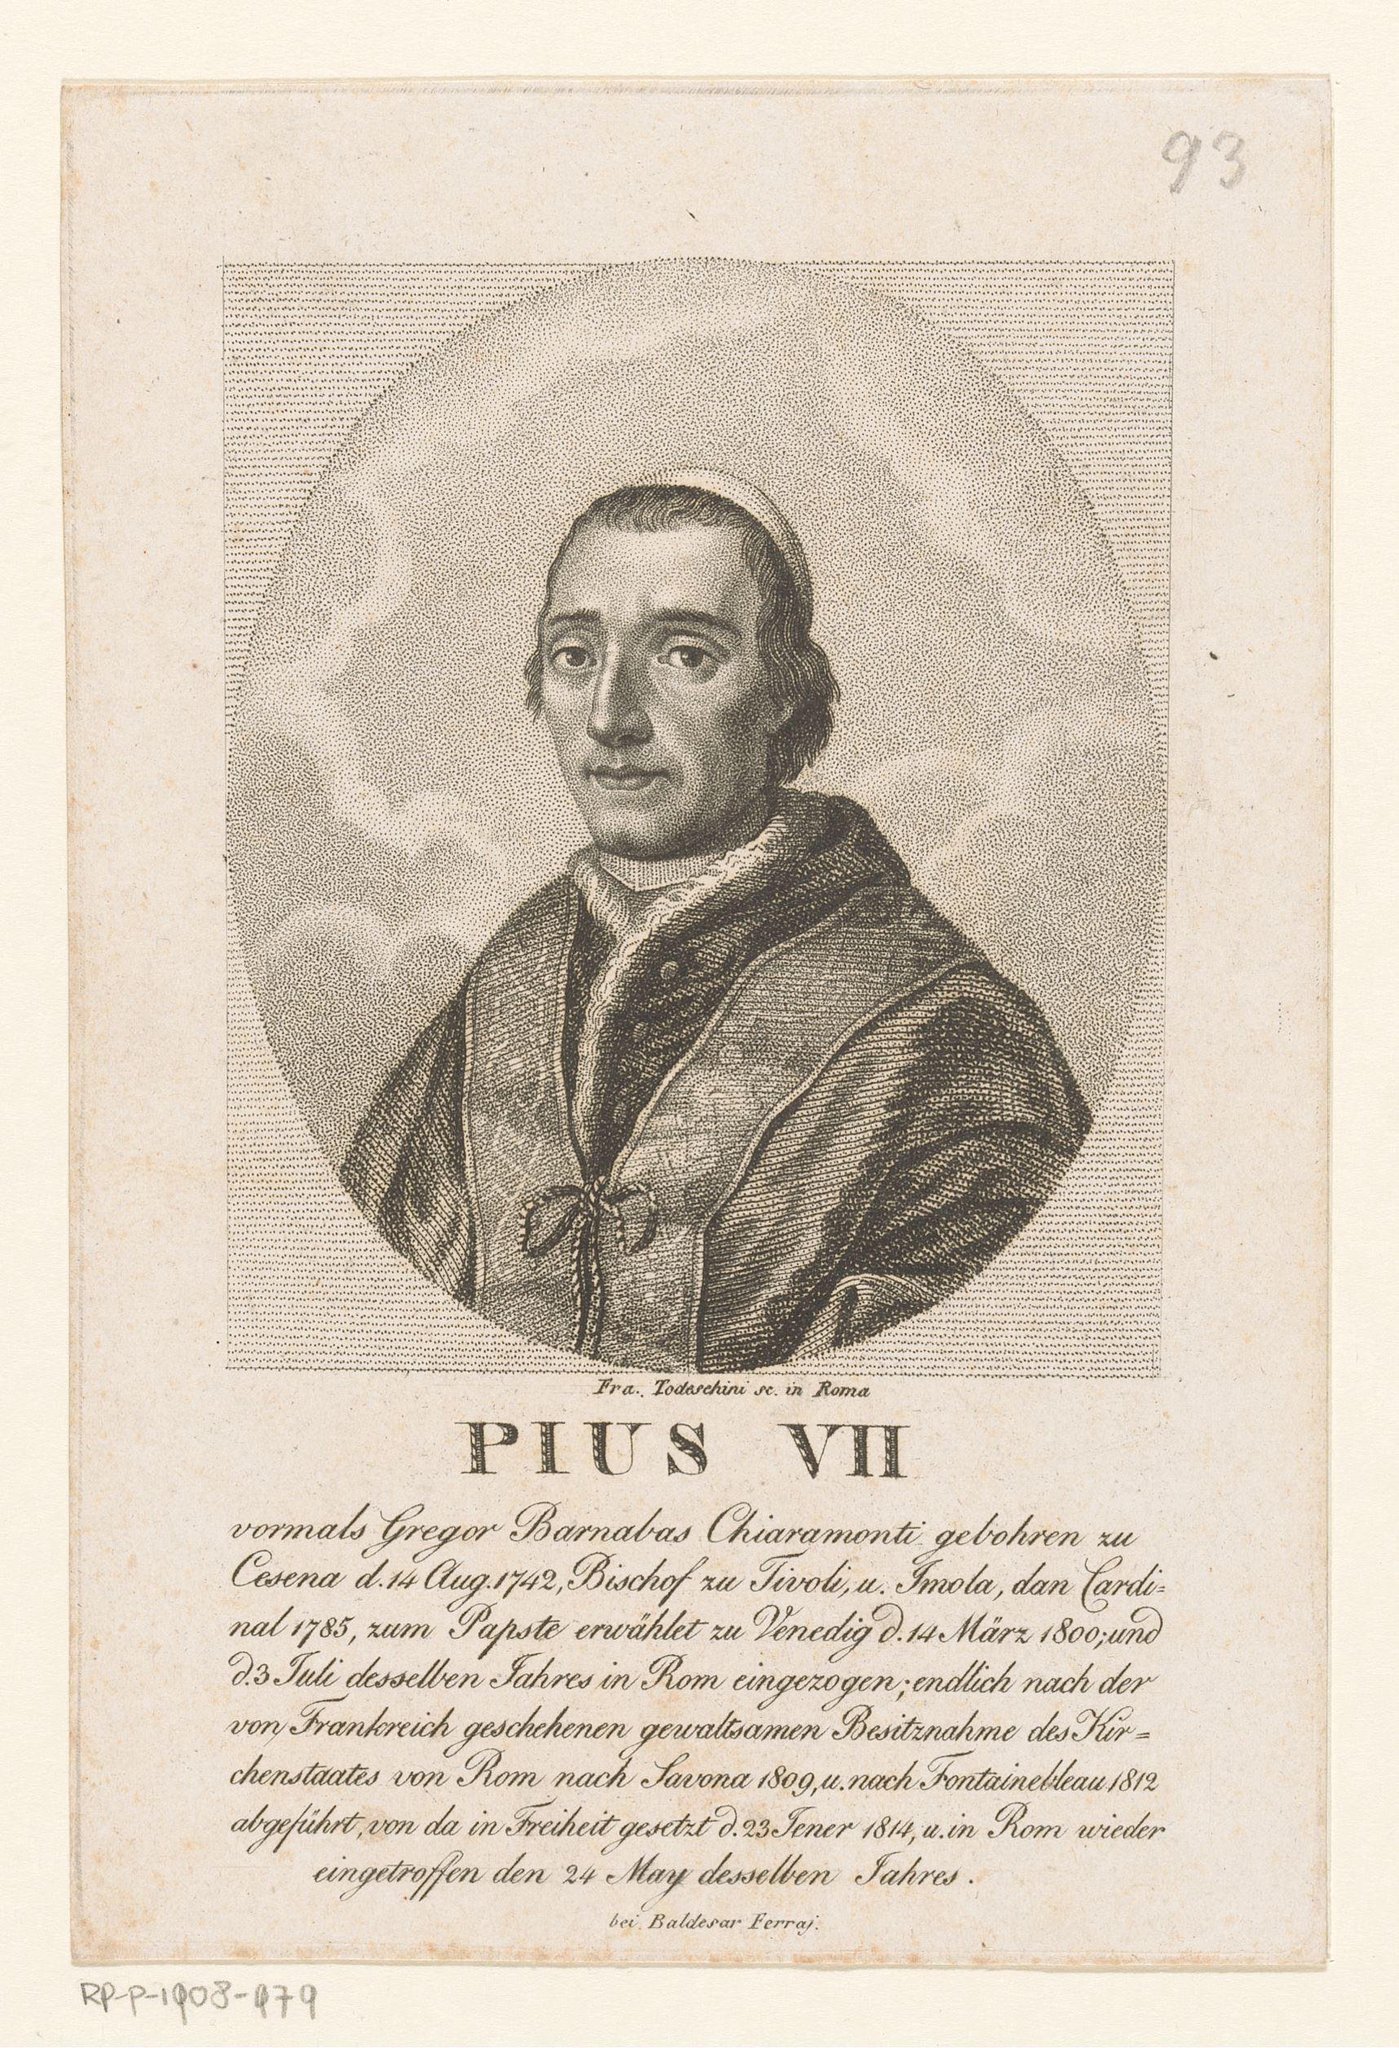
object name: print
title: Portret van paus Pius VII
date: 1800-1899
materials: paper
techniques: engraving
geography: rome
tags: clergyman, pius vii, historical persons, pope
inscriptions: collector's mark: Lugt 2228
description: Onder het portret acht regels tekst in het Duits.